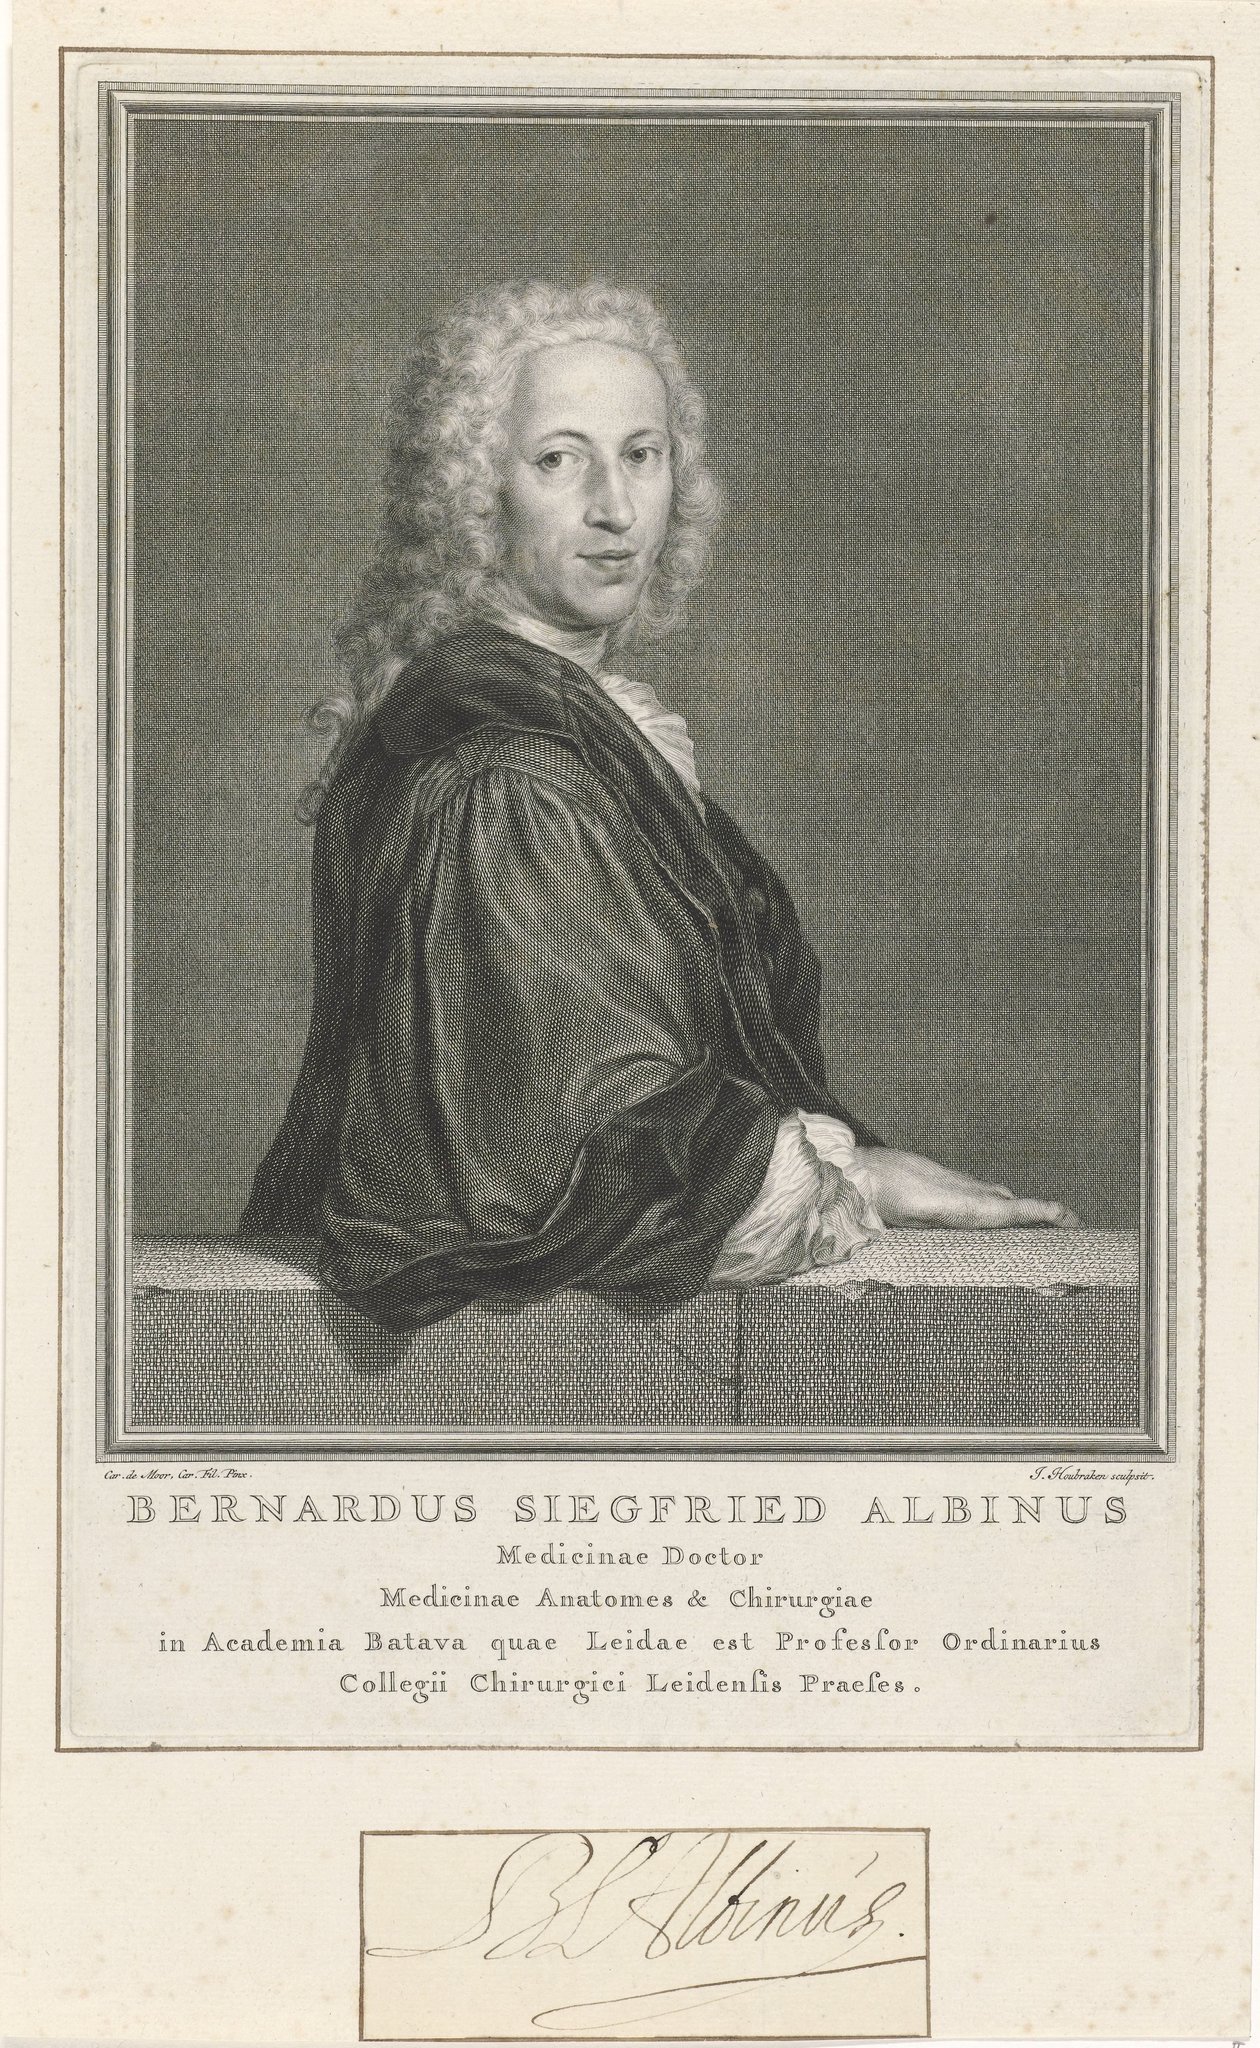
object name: print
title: Bernardus Siegfried Albinus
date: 1721-1751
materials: paper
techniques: engraving, etching, pen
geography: amsterdam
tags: leiden, bernard siegfried albinus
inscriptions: collector's mark: Lugt 12, inscription: ‘BSAlbinus’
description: Portret ten halven lijve naar rechts van Bernard Siegfried Albinus, zijn rechterarm leunend op een plint. Onder het portret zijn naam en titel in vijf regels in het Latijn.